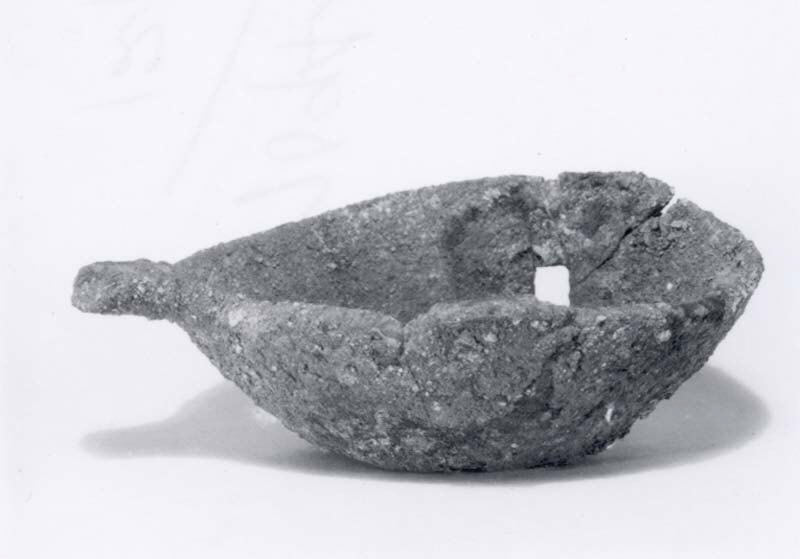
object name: ladle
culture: iranian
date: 900-801 BCE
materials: bronze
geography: iran